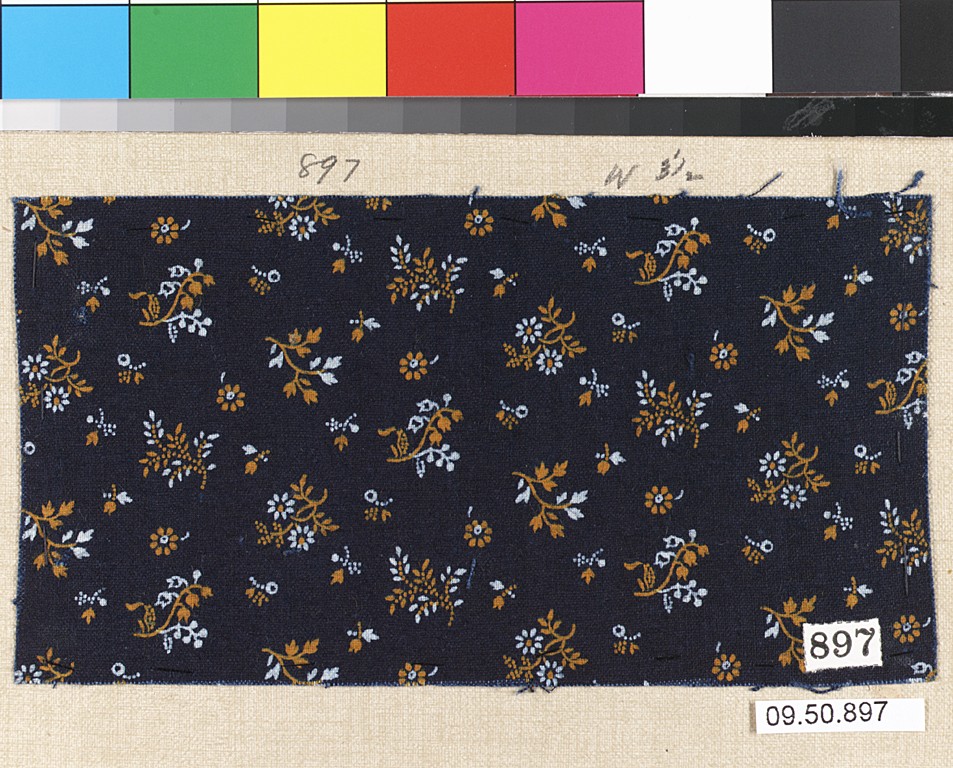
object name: piece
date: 1801-1900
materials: cotton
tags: flowers,leaves